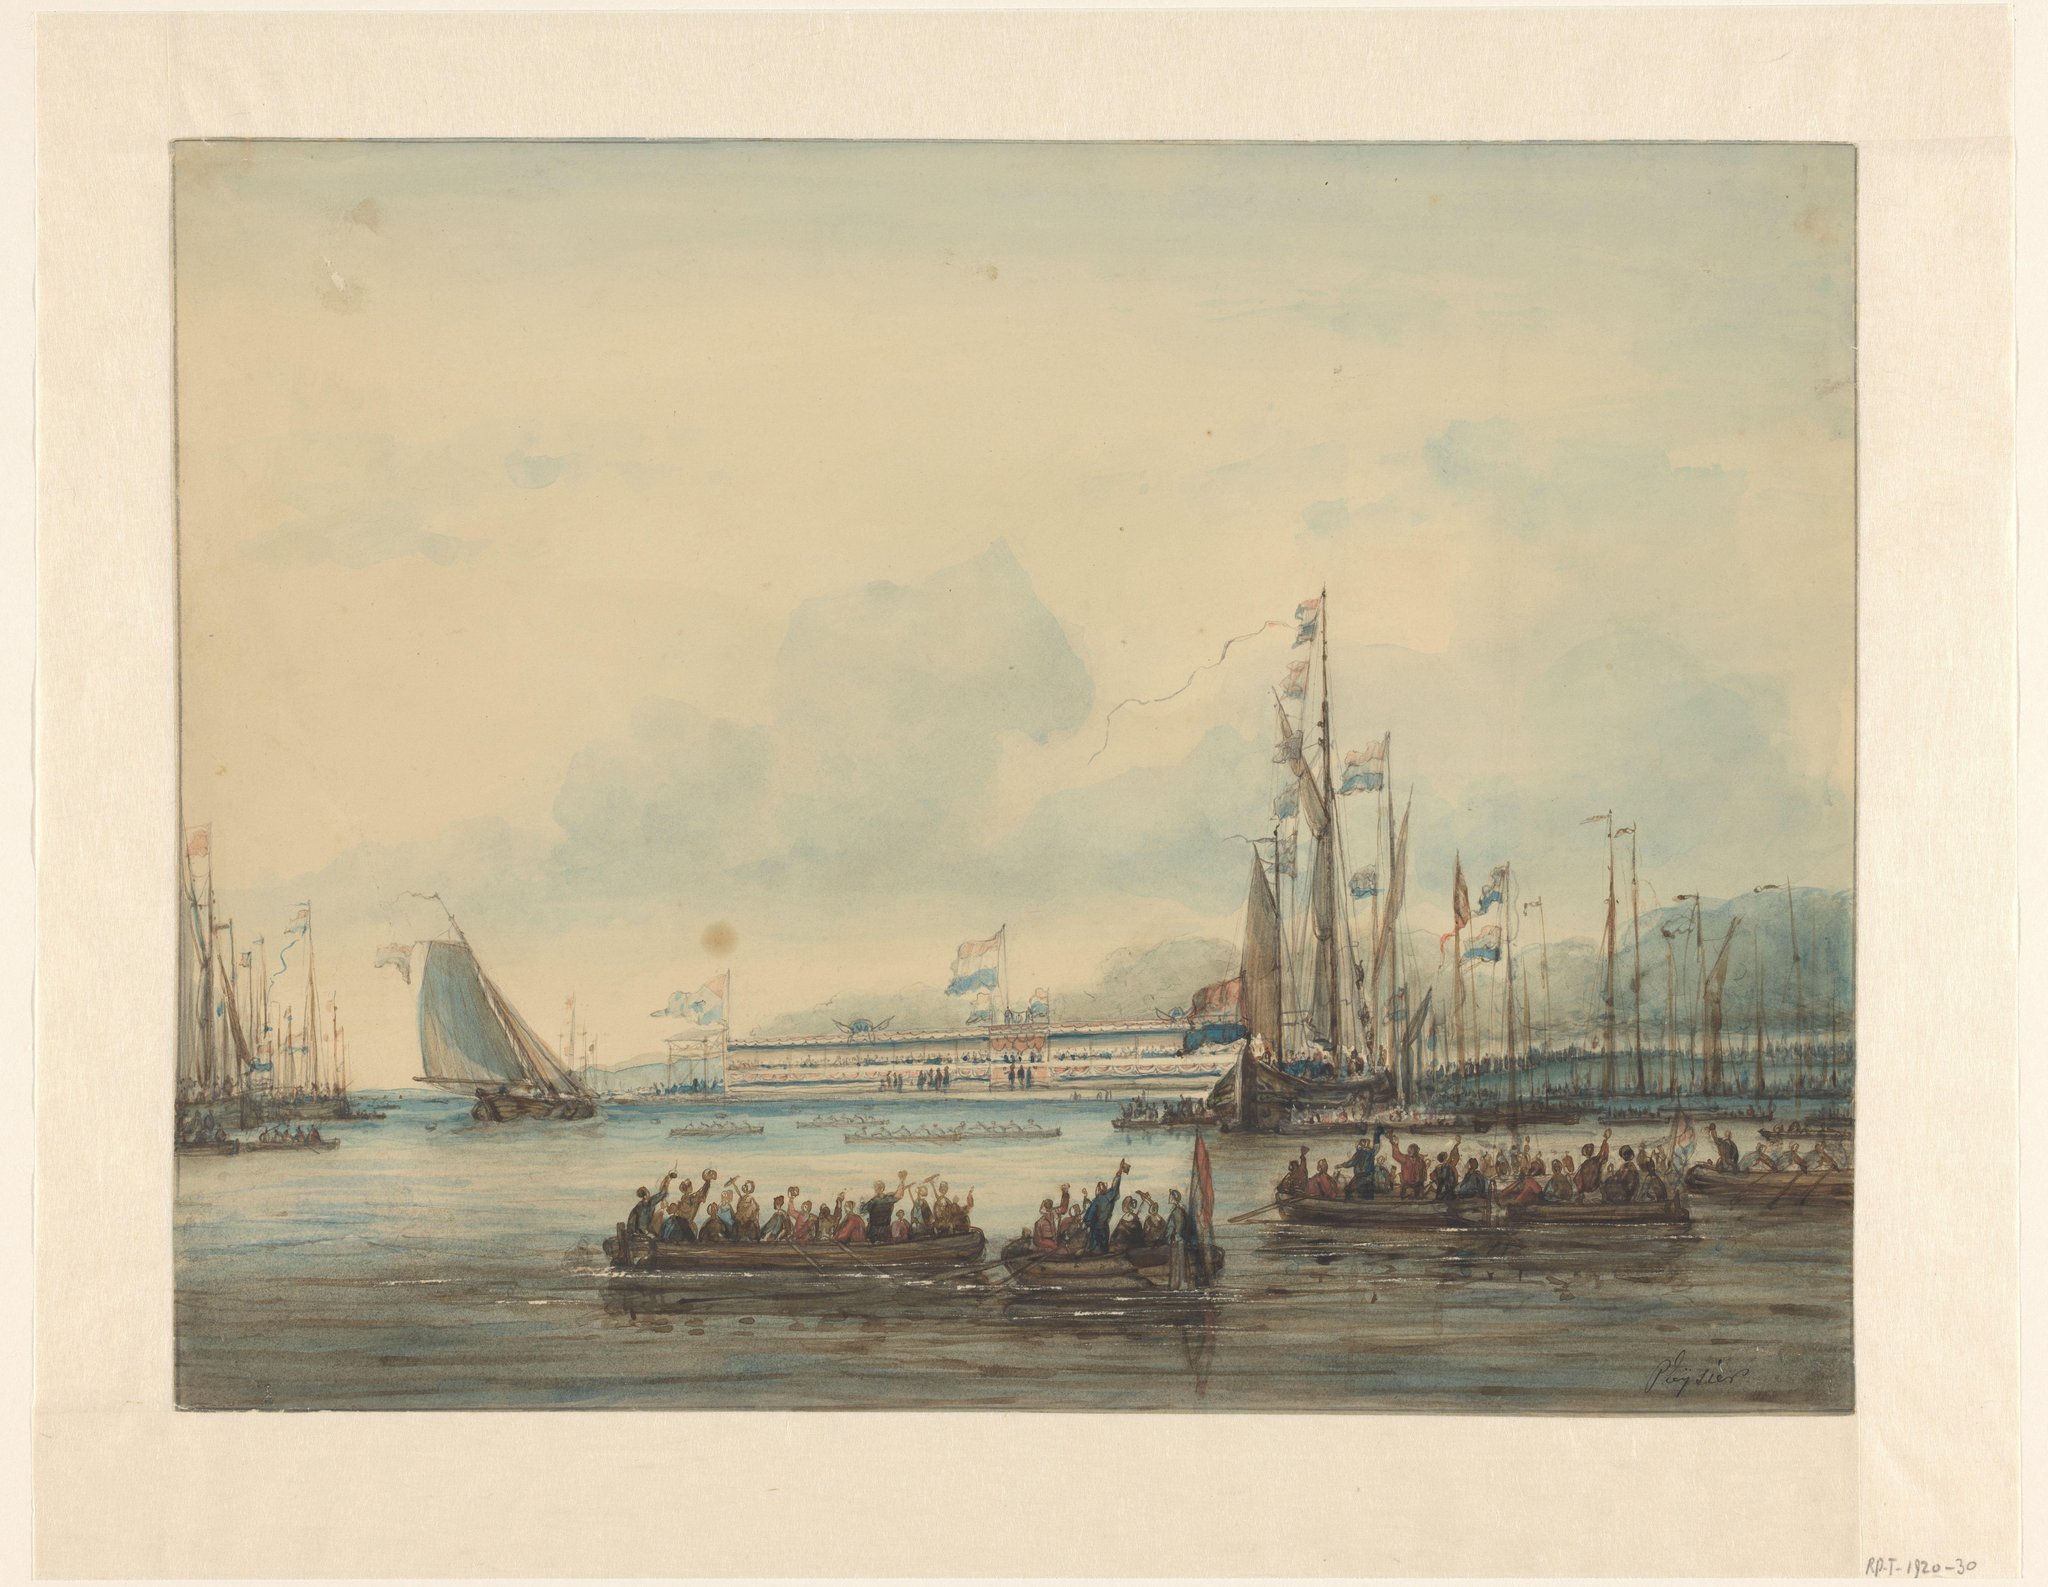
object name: drawing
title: Roeiwedstrijd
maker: ary pleijsier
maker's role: draughtsman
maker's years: 1819-1879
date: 1829-1879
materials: ink, paper, pencil, watercolor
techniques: brush, pen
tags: rowing, canoeing, etc. (sport)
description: Vanaf een tribune met Nederlandse vlaggen en vanaf sloepen in het water kijken toeschouwers naar de roeiwedstrijd.